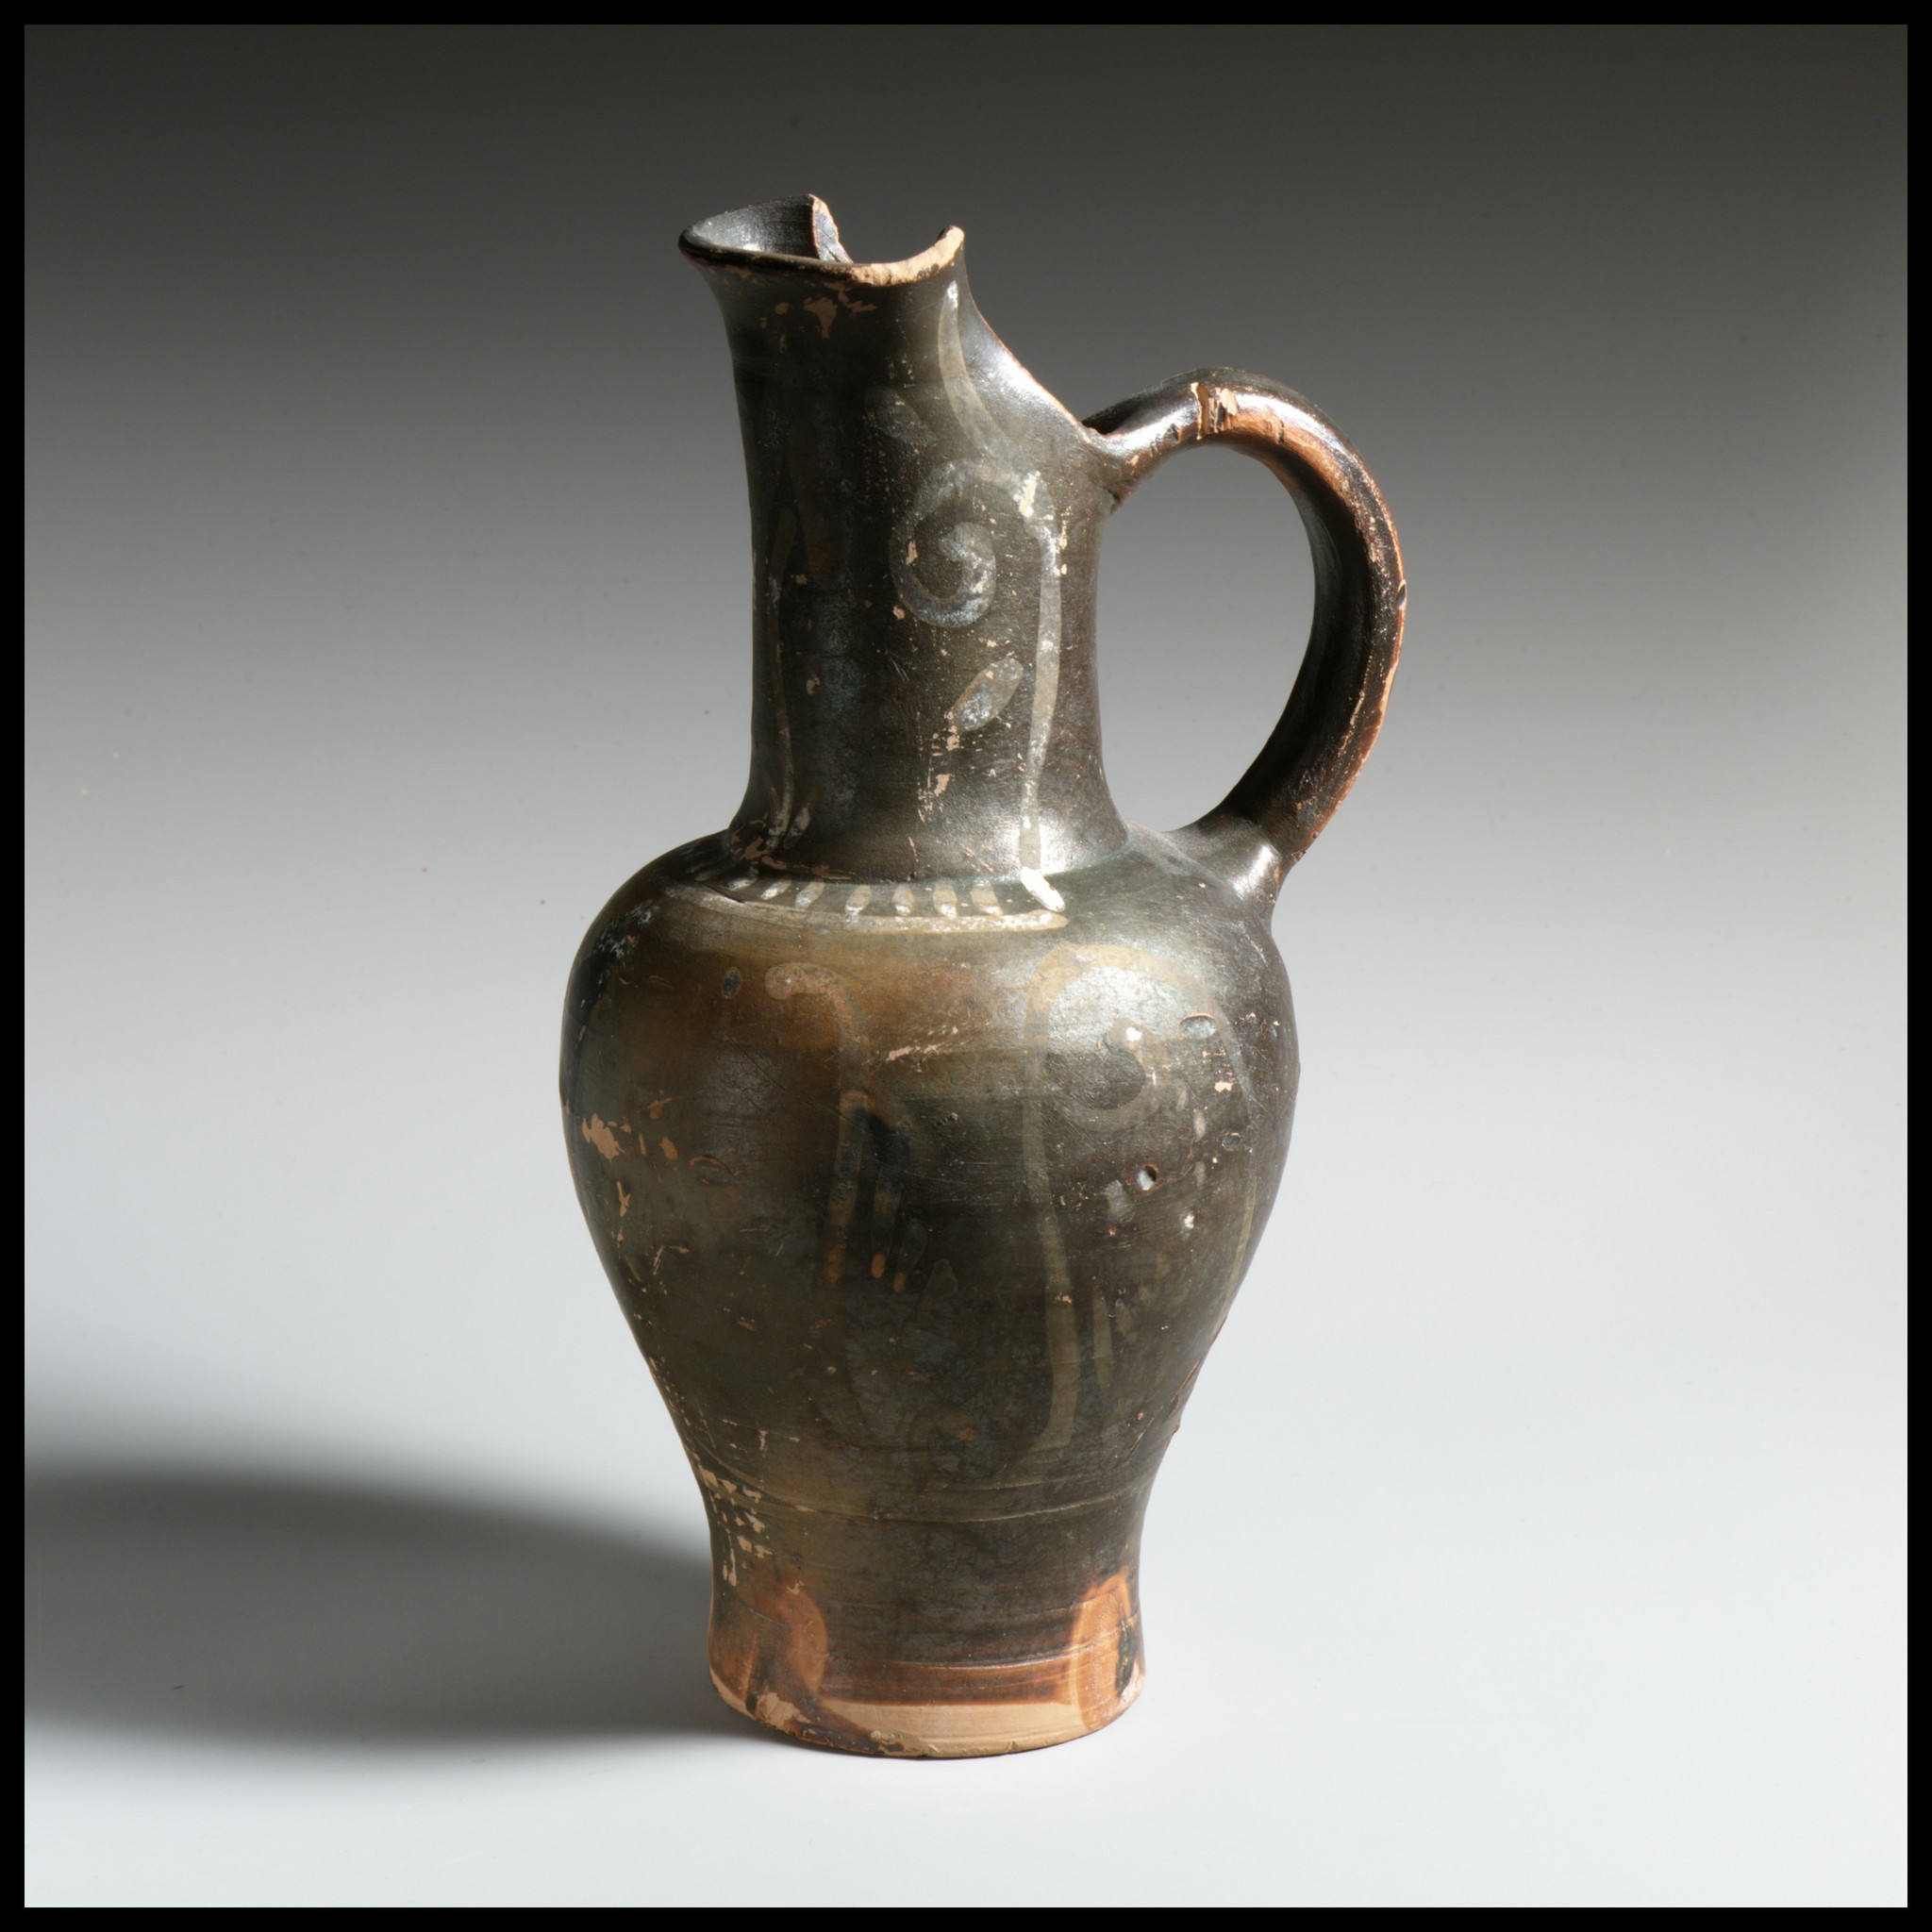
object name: oinochoe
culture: etruscan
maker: phantom group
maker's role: artist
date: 400-301 BCE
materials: terracotta